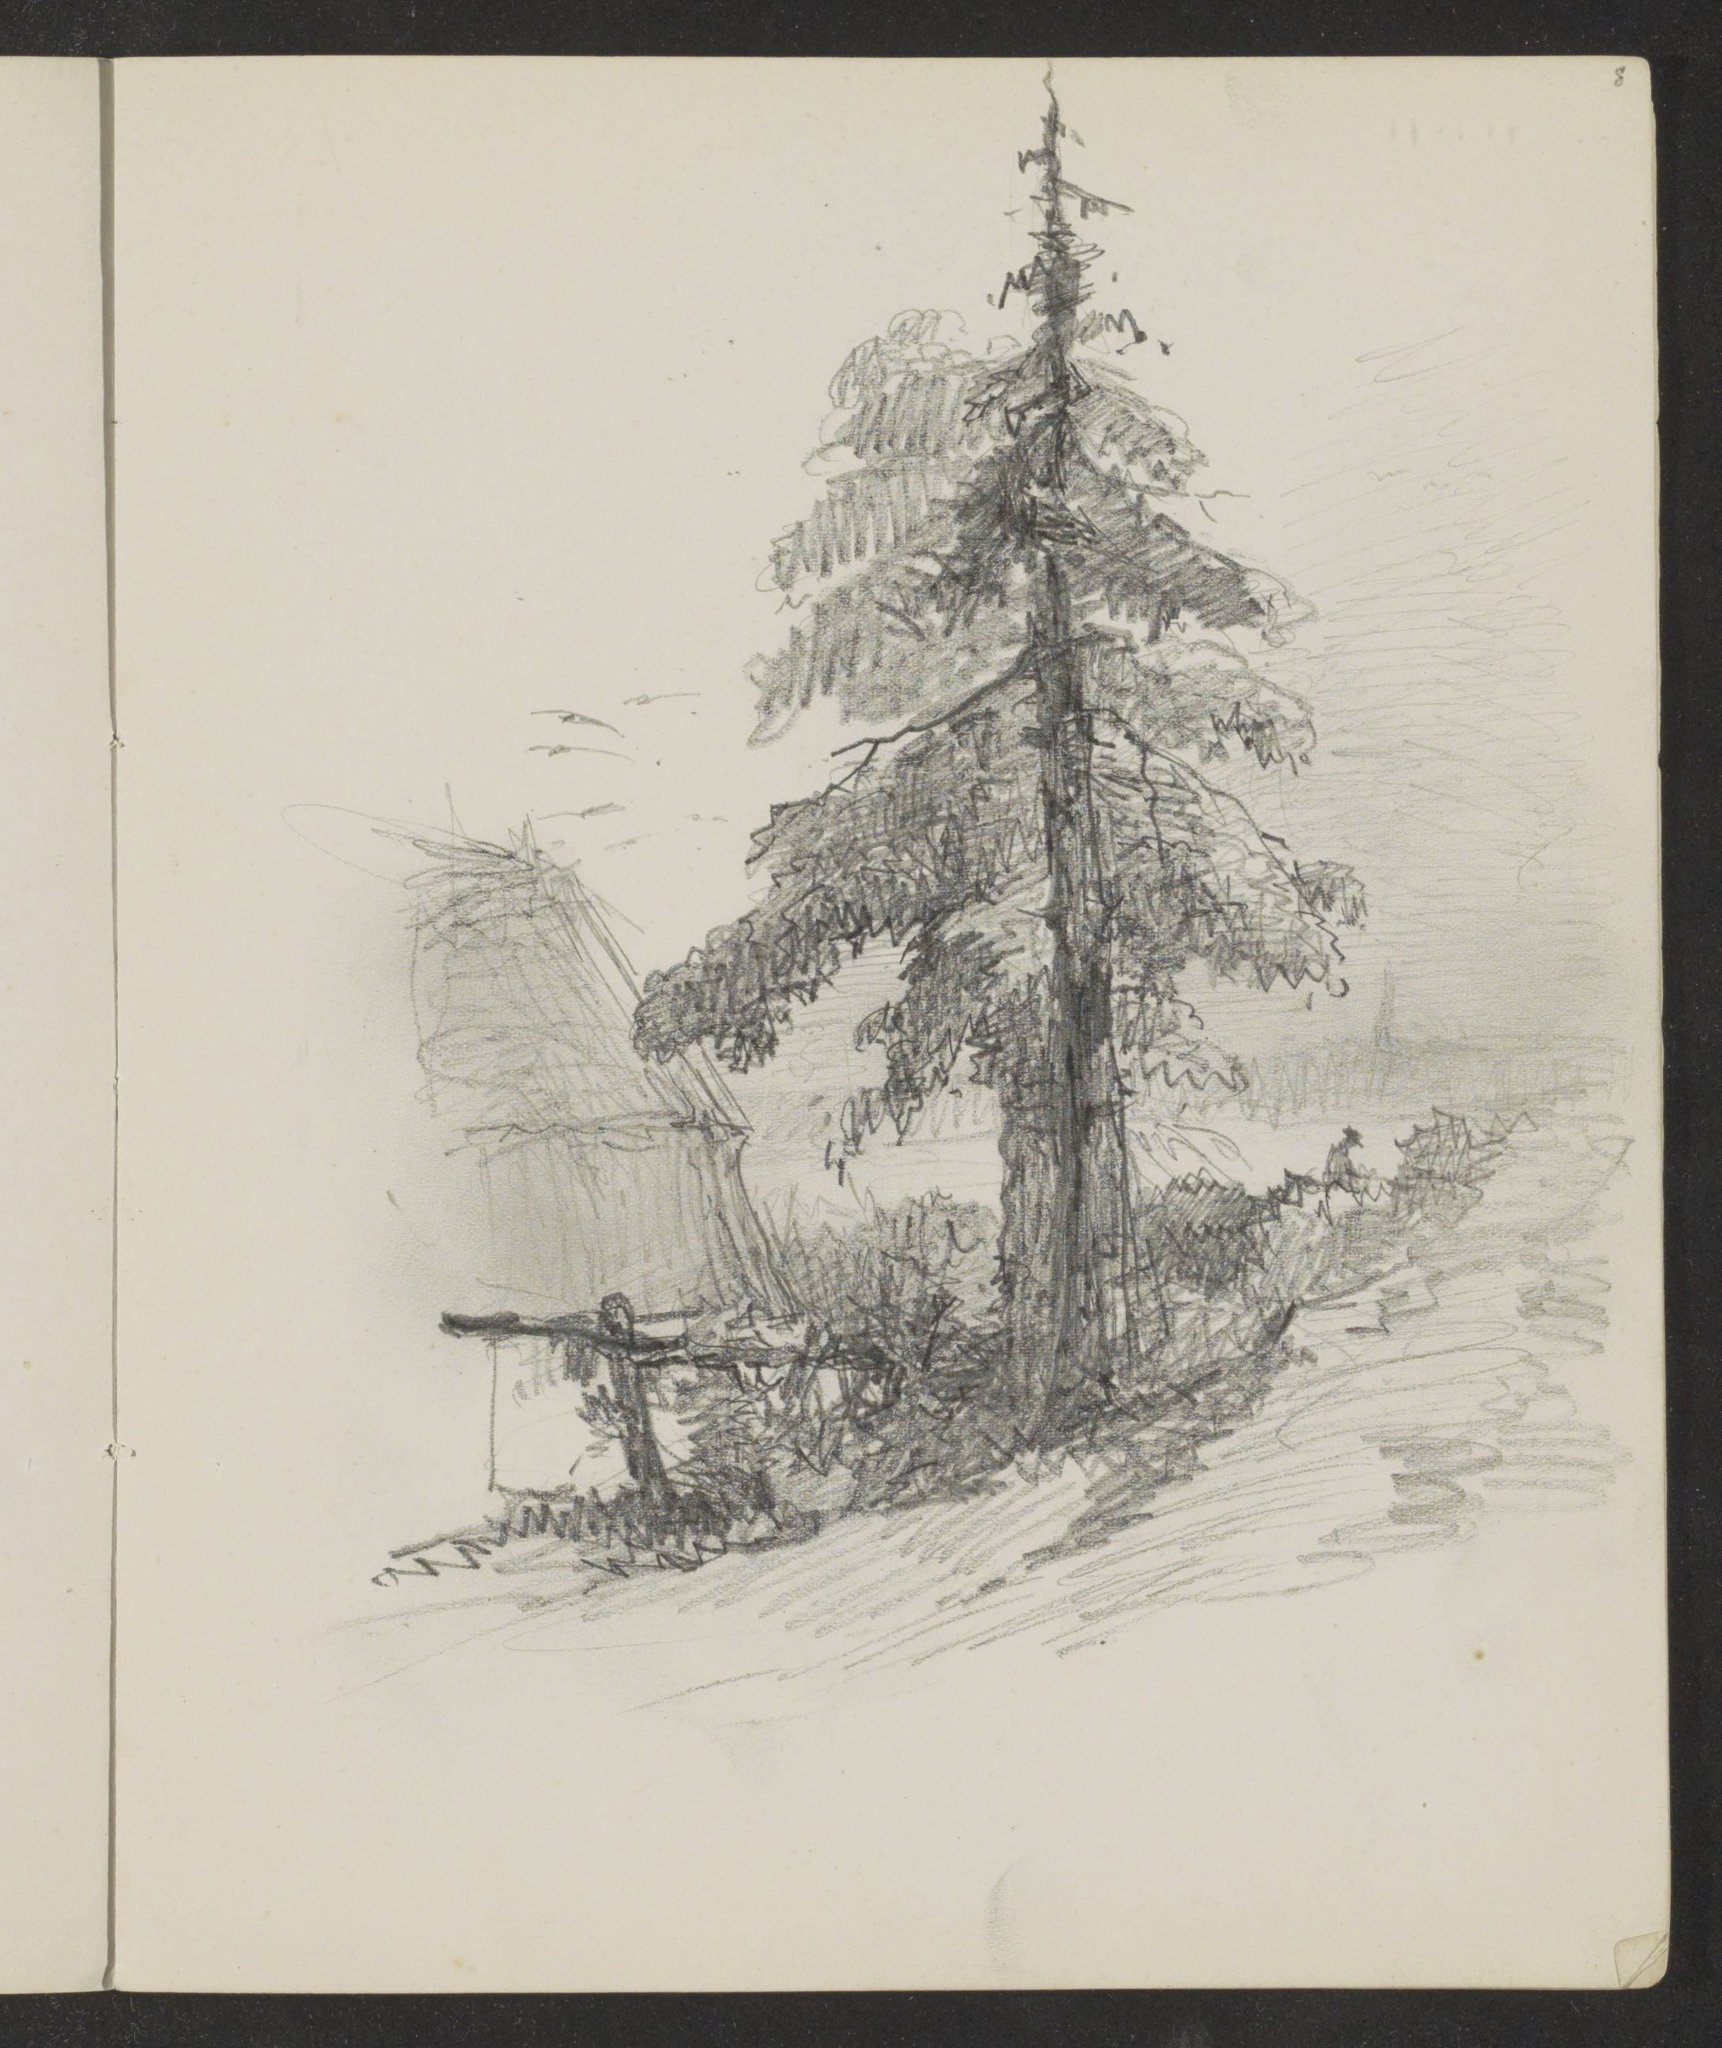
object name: sketchbook leaf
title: Landschap met een boom aan een waterkant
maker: maria vos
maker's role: draughtsman, painter, print maker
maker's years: 1824-1906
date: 1886-1890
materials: paper, pencil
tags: landscapes with waters, waterscapes, seascapes (in the temperate zone)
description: Blad 8 recto uit een schetsboek met 17 bladen.